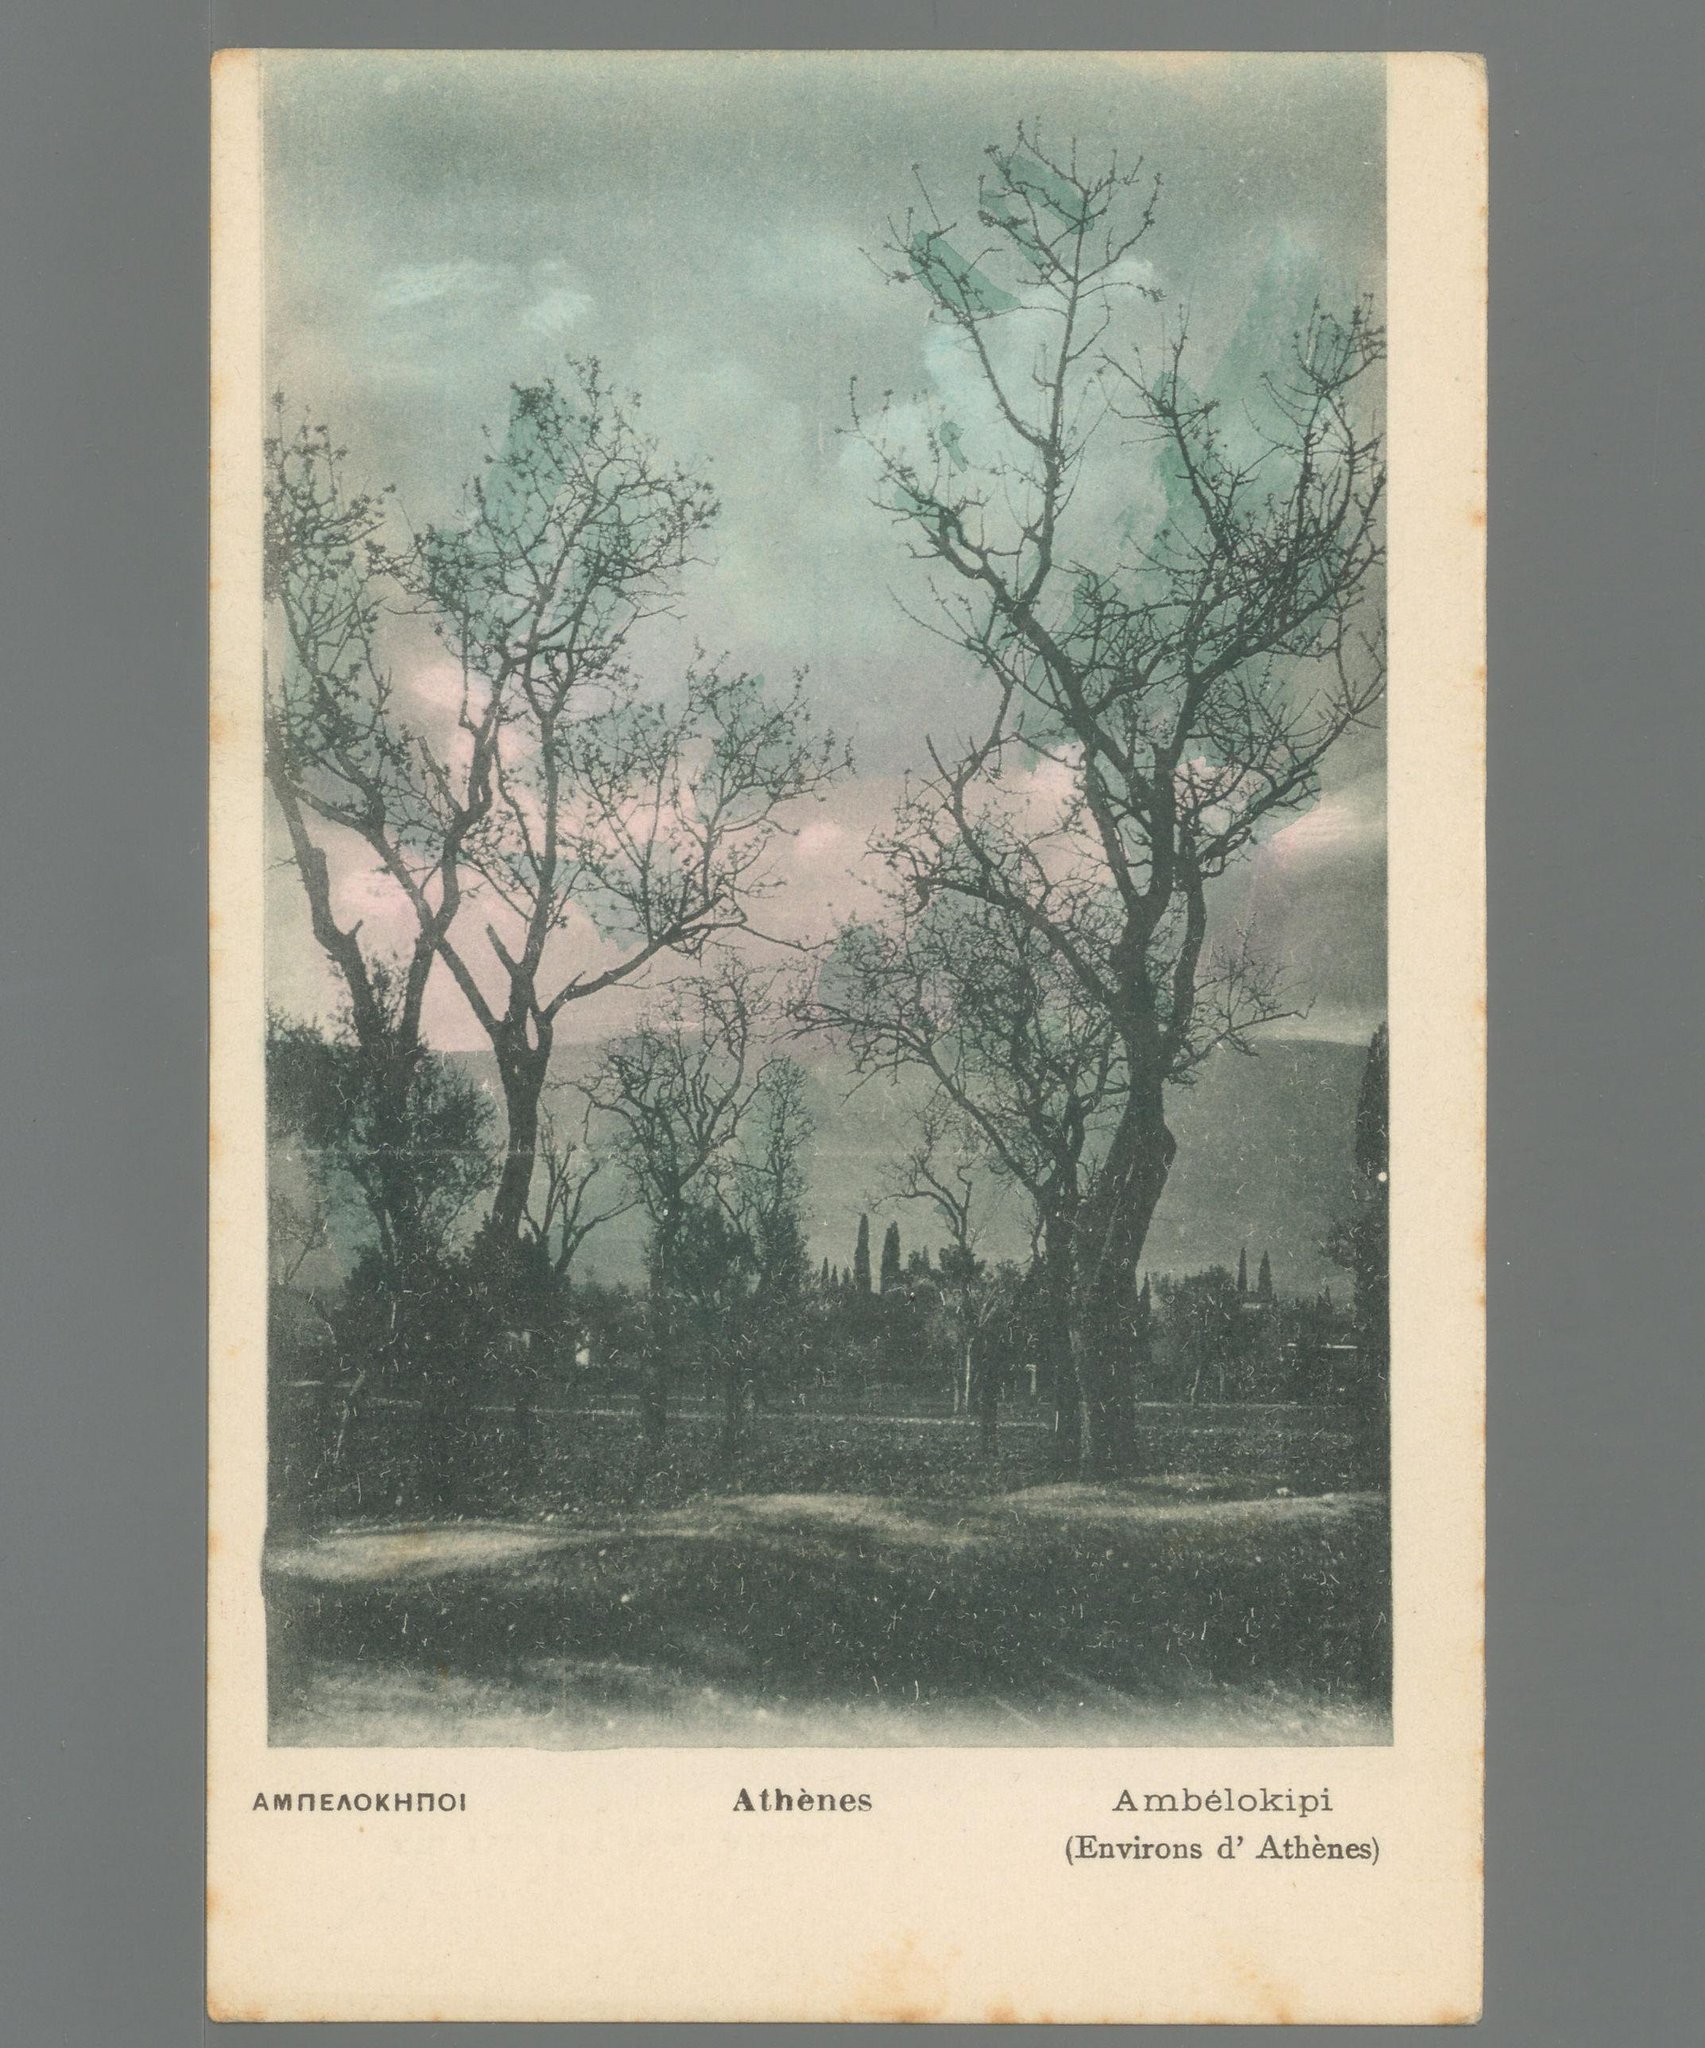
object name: photomechanical print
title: Athènes. Ambélokipi (Environs d'Athènes)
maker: Anonymous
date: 1906-1930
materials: cardboard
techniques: photograph, hand coloring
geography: athens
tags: city-view, and landscape with man-made constructions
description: Voor de Franse titel staat de titel in het Grieks.